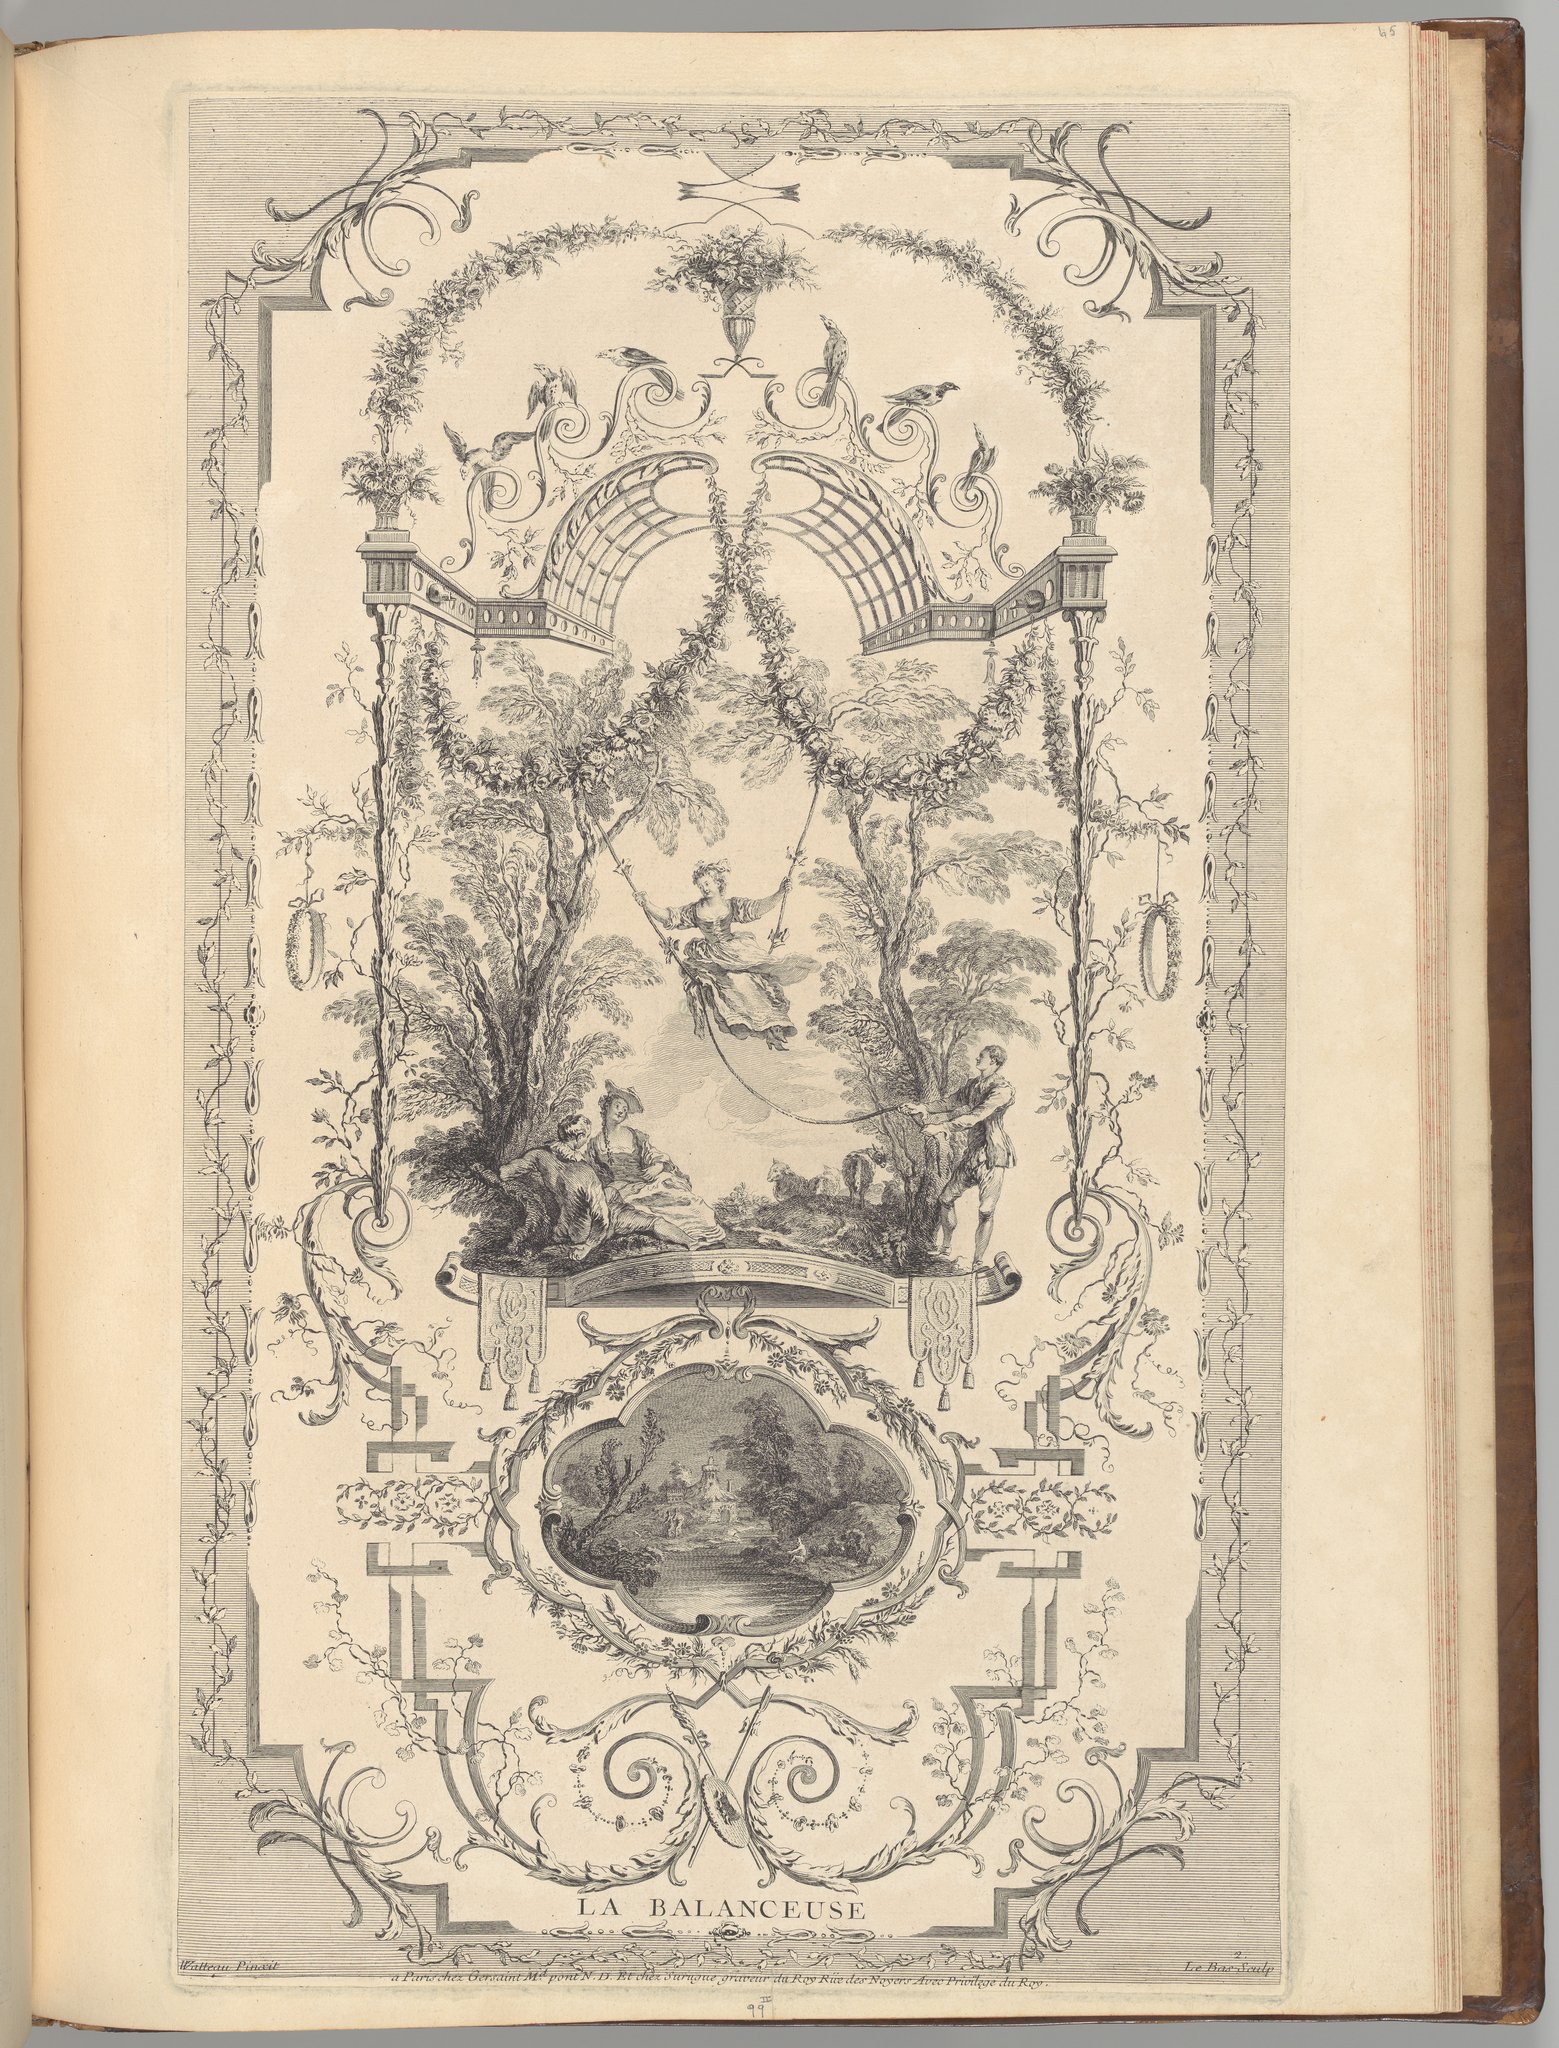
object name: print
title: L'Oeuvre D'Antoine Watteau Pientre du Roy en son Academie Roïale de Peinture et Sculpture Gravé d'après ses Tableaux & Desseins originaux...par les Soins de M. de Jullienne, Volume III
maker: antoine watteau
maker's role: artist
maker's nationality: french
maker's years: 1684-1721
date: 1740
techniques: engraving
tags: men,female nudes